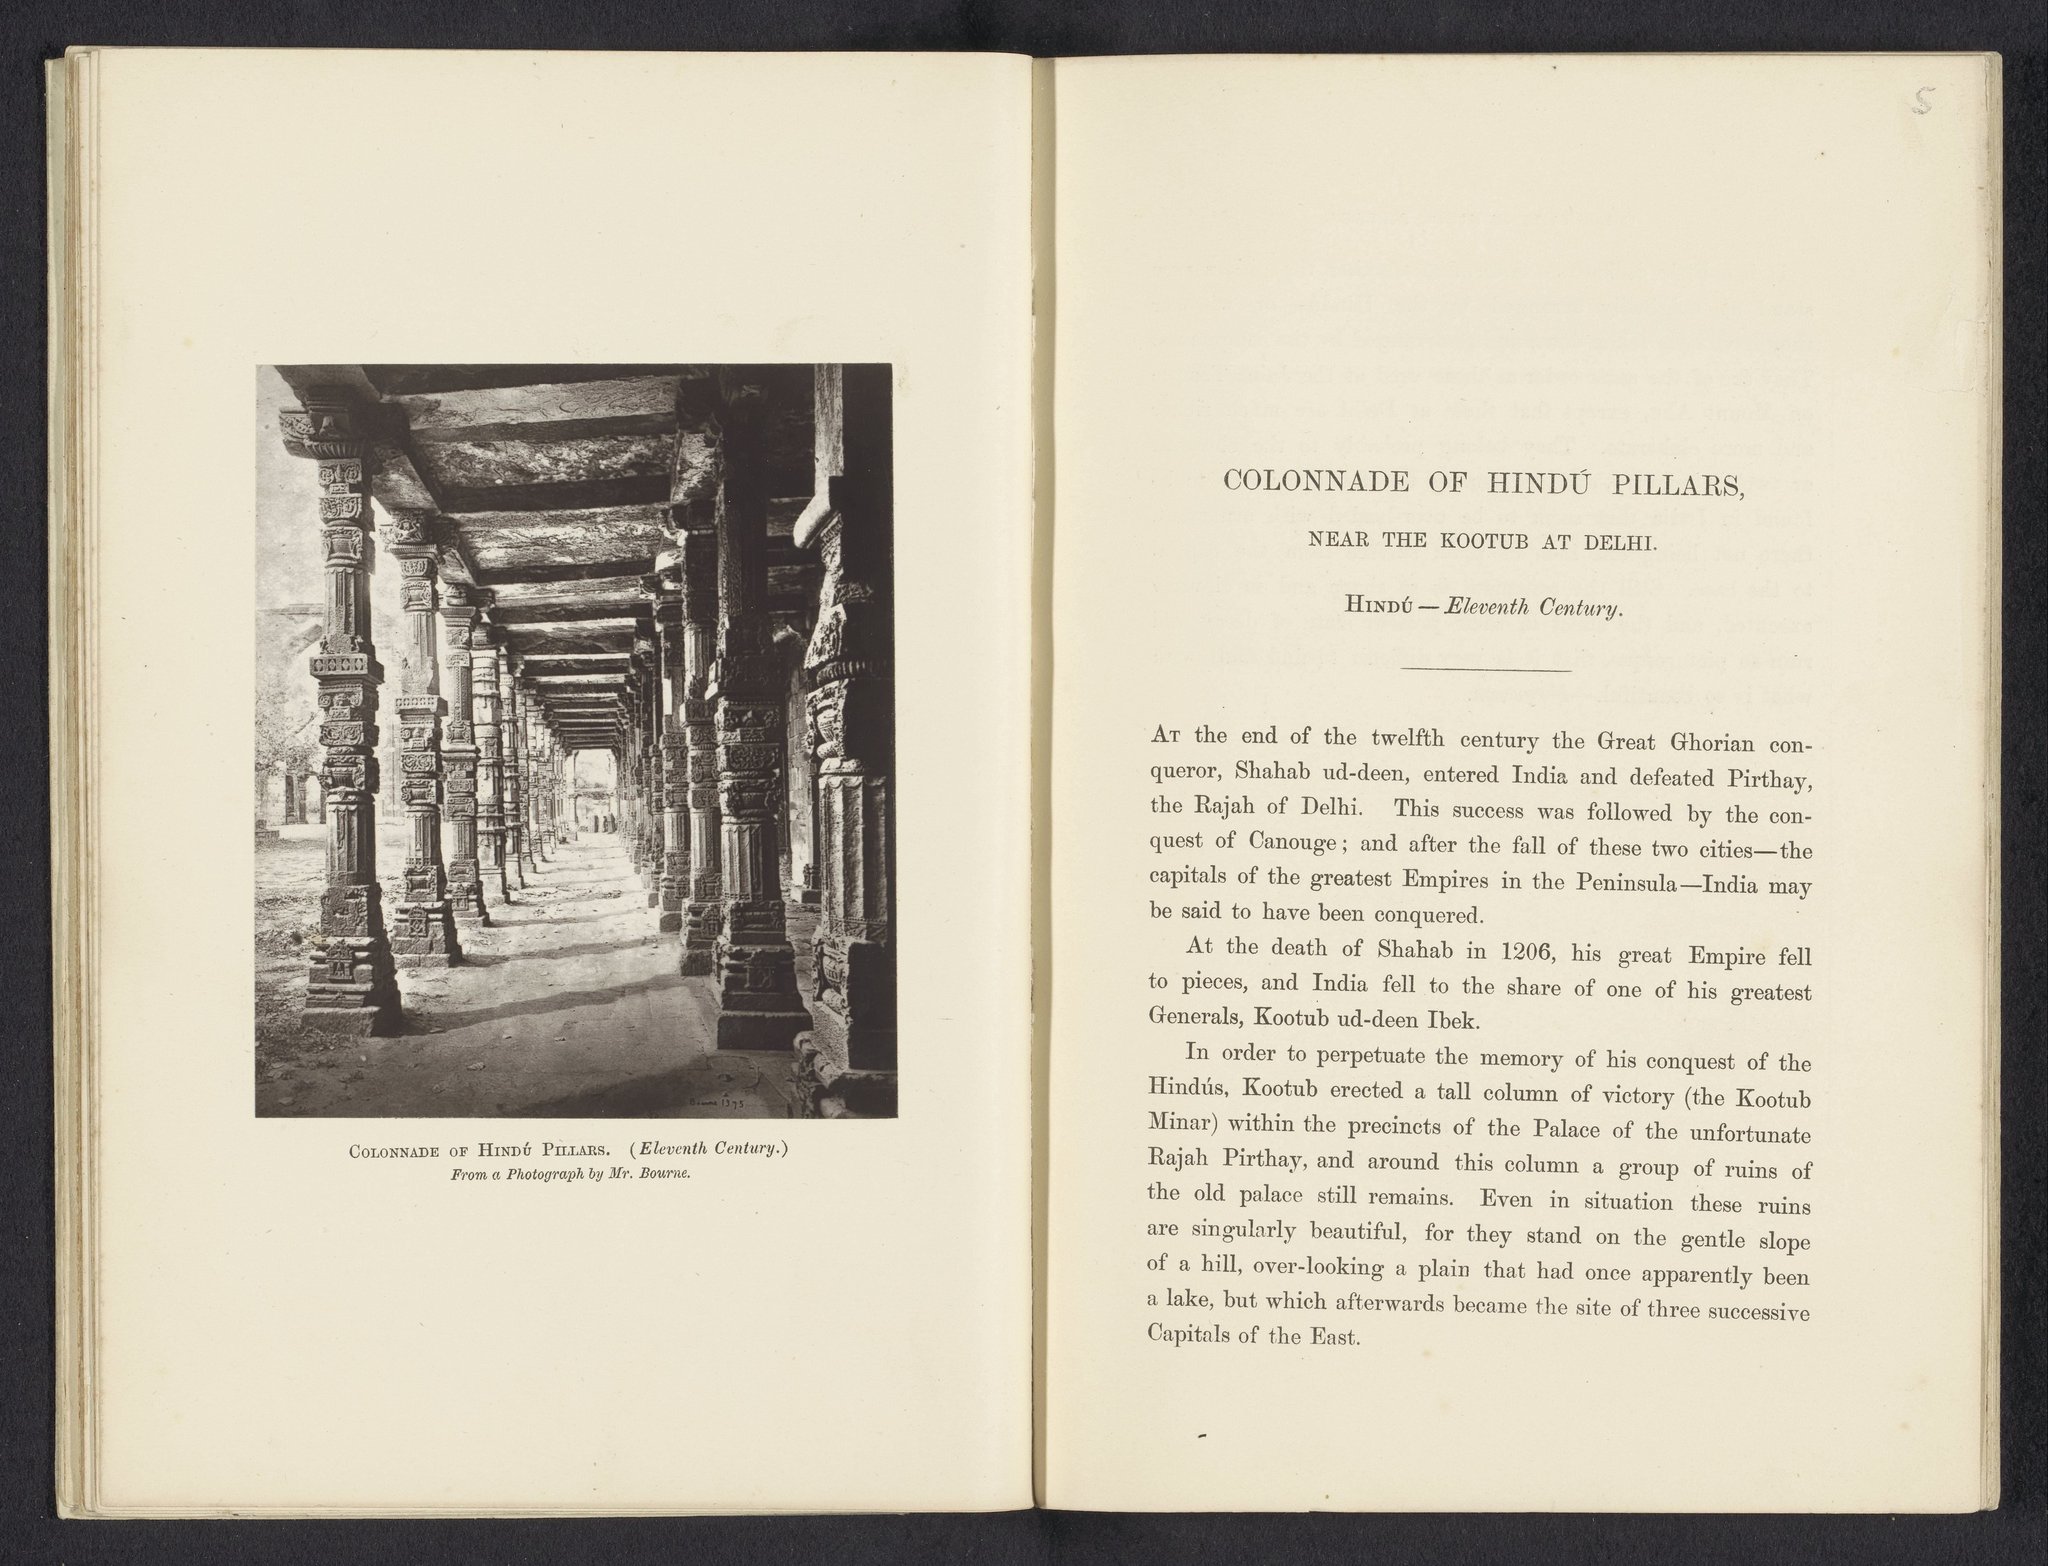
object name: photomechanical print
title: Colonnade in the Qutb Minar complex at Delhi, India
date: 1864-1869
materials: paper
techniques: woodburytype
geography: delhi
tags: colonnade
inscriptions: caption: ‘COLONNADE OF HINDÚ PILLARS. (Eleventh Century.)/ From a Photograph by Mr. Bourne.’